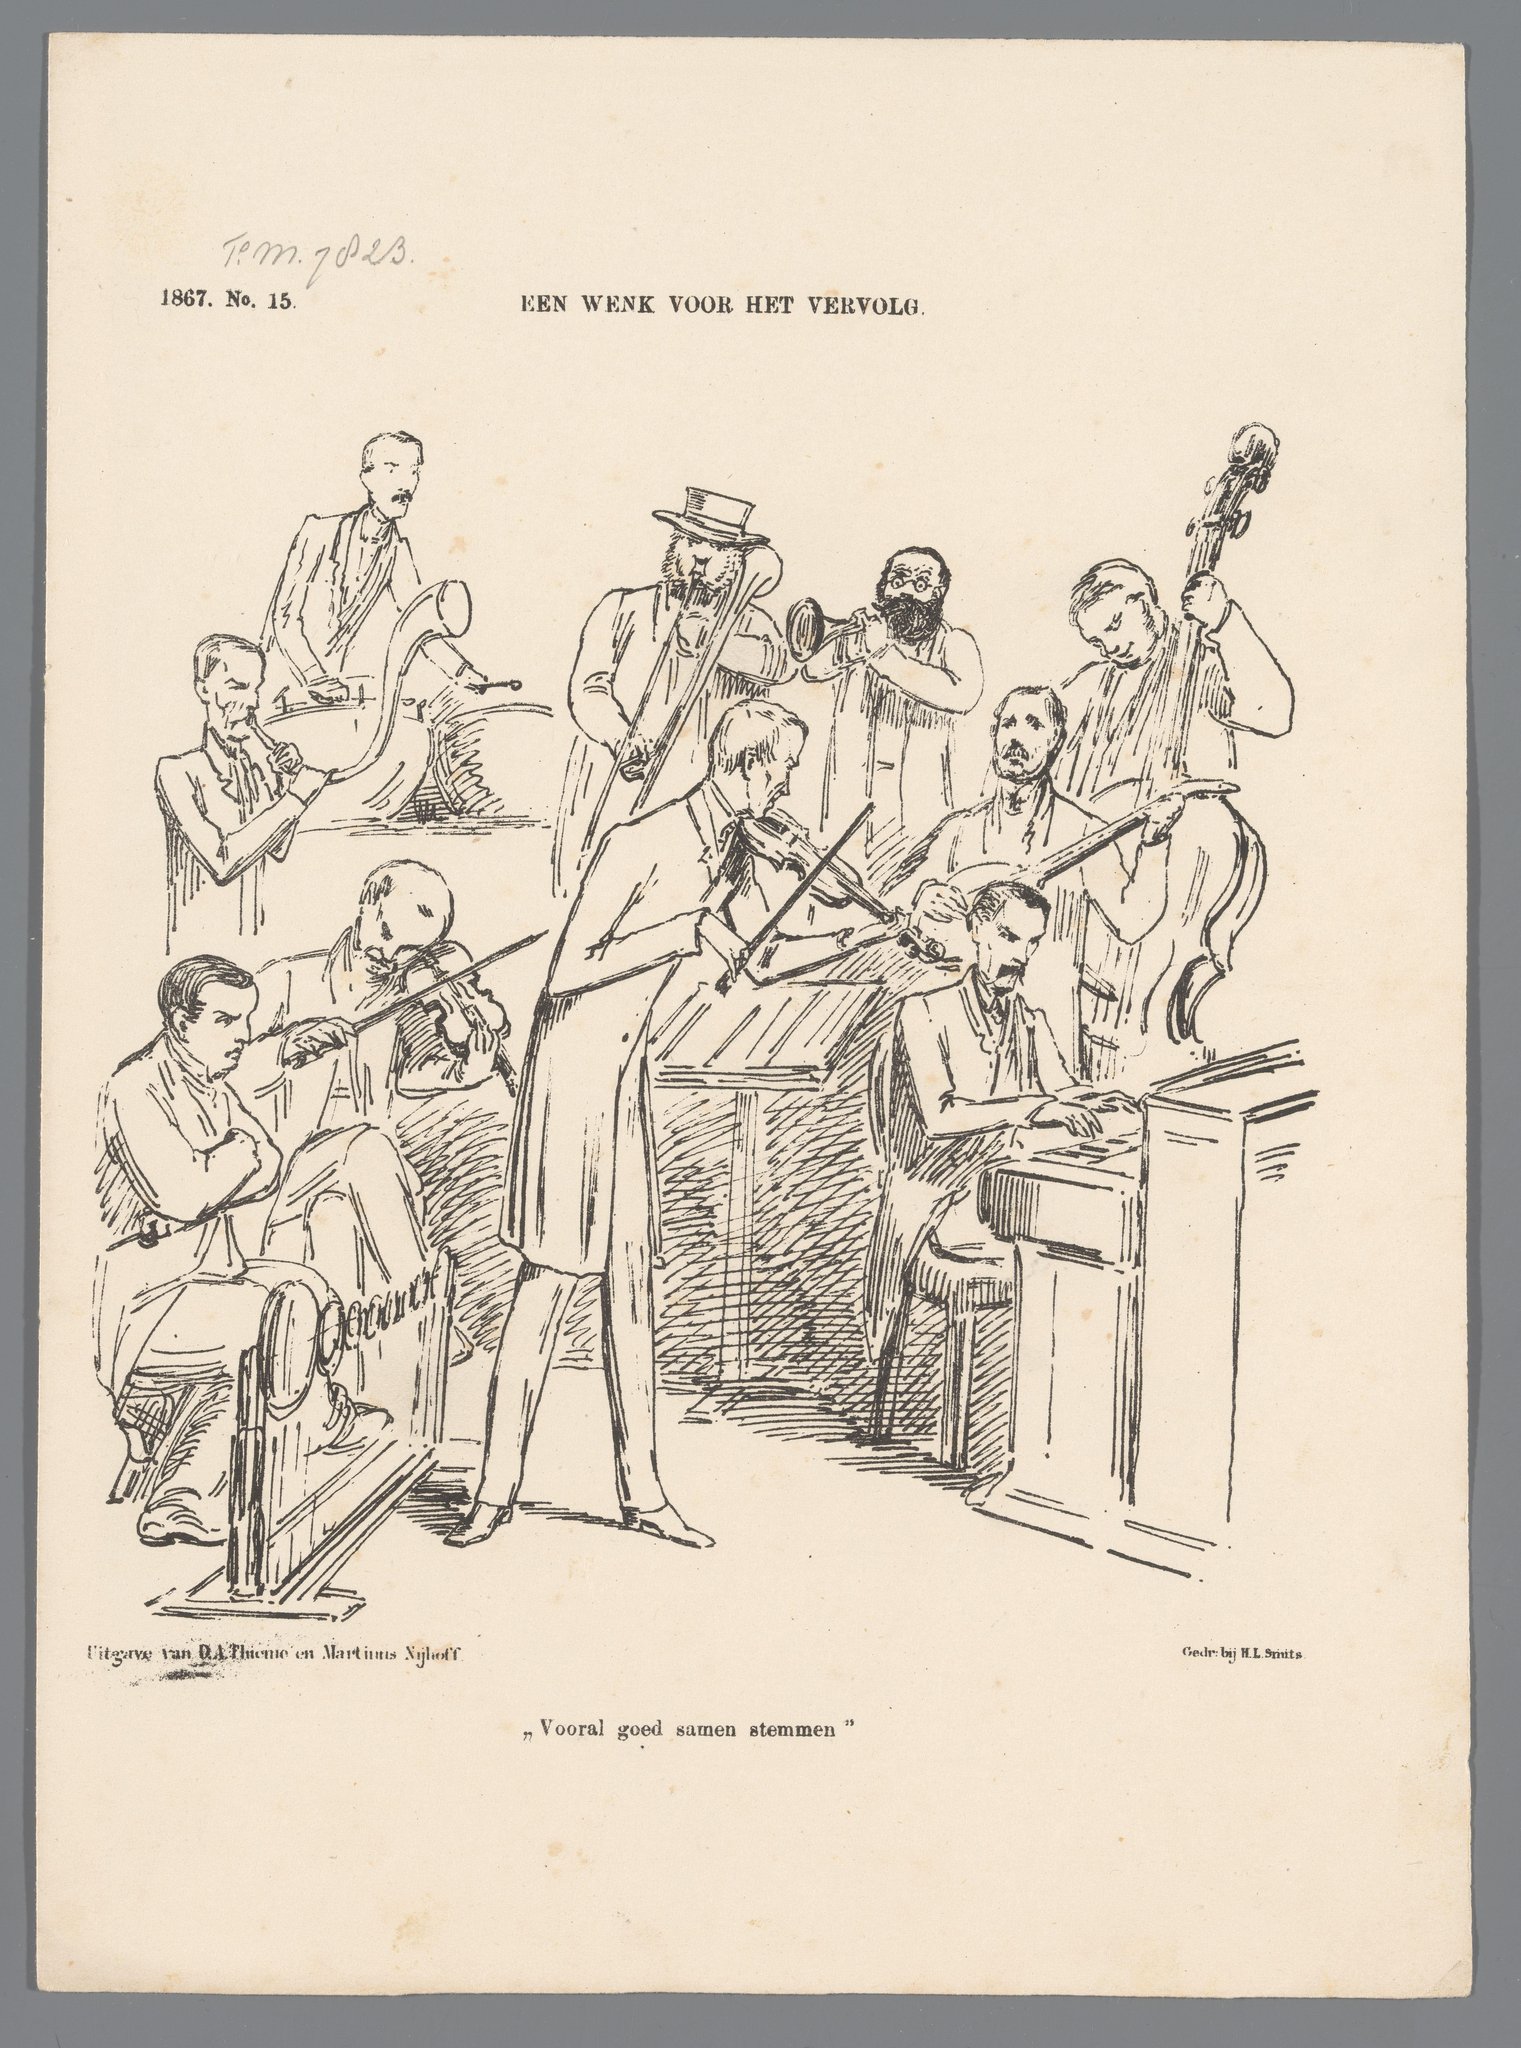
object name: cartoon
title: Spotprent met Thorbecke als leider van het orkest van de oppositie, 1867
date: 1867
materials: paper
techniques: lithograph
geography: netherlands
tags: johan rudolf thorbecke, small group of musicians, chamber orchestra, jazz band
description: Spotprent met Thorbecke die als eerste violist het orkest van de oppositie leidt. Met andere ministers op andere instrumenten. Plaat verschenen bij het weekblad De Nederlandsche Spectator, nr. 15, 13 april 1867.